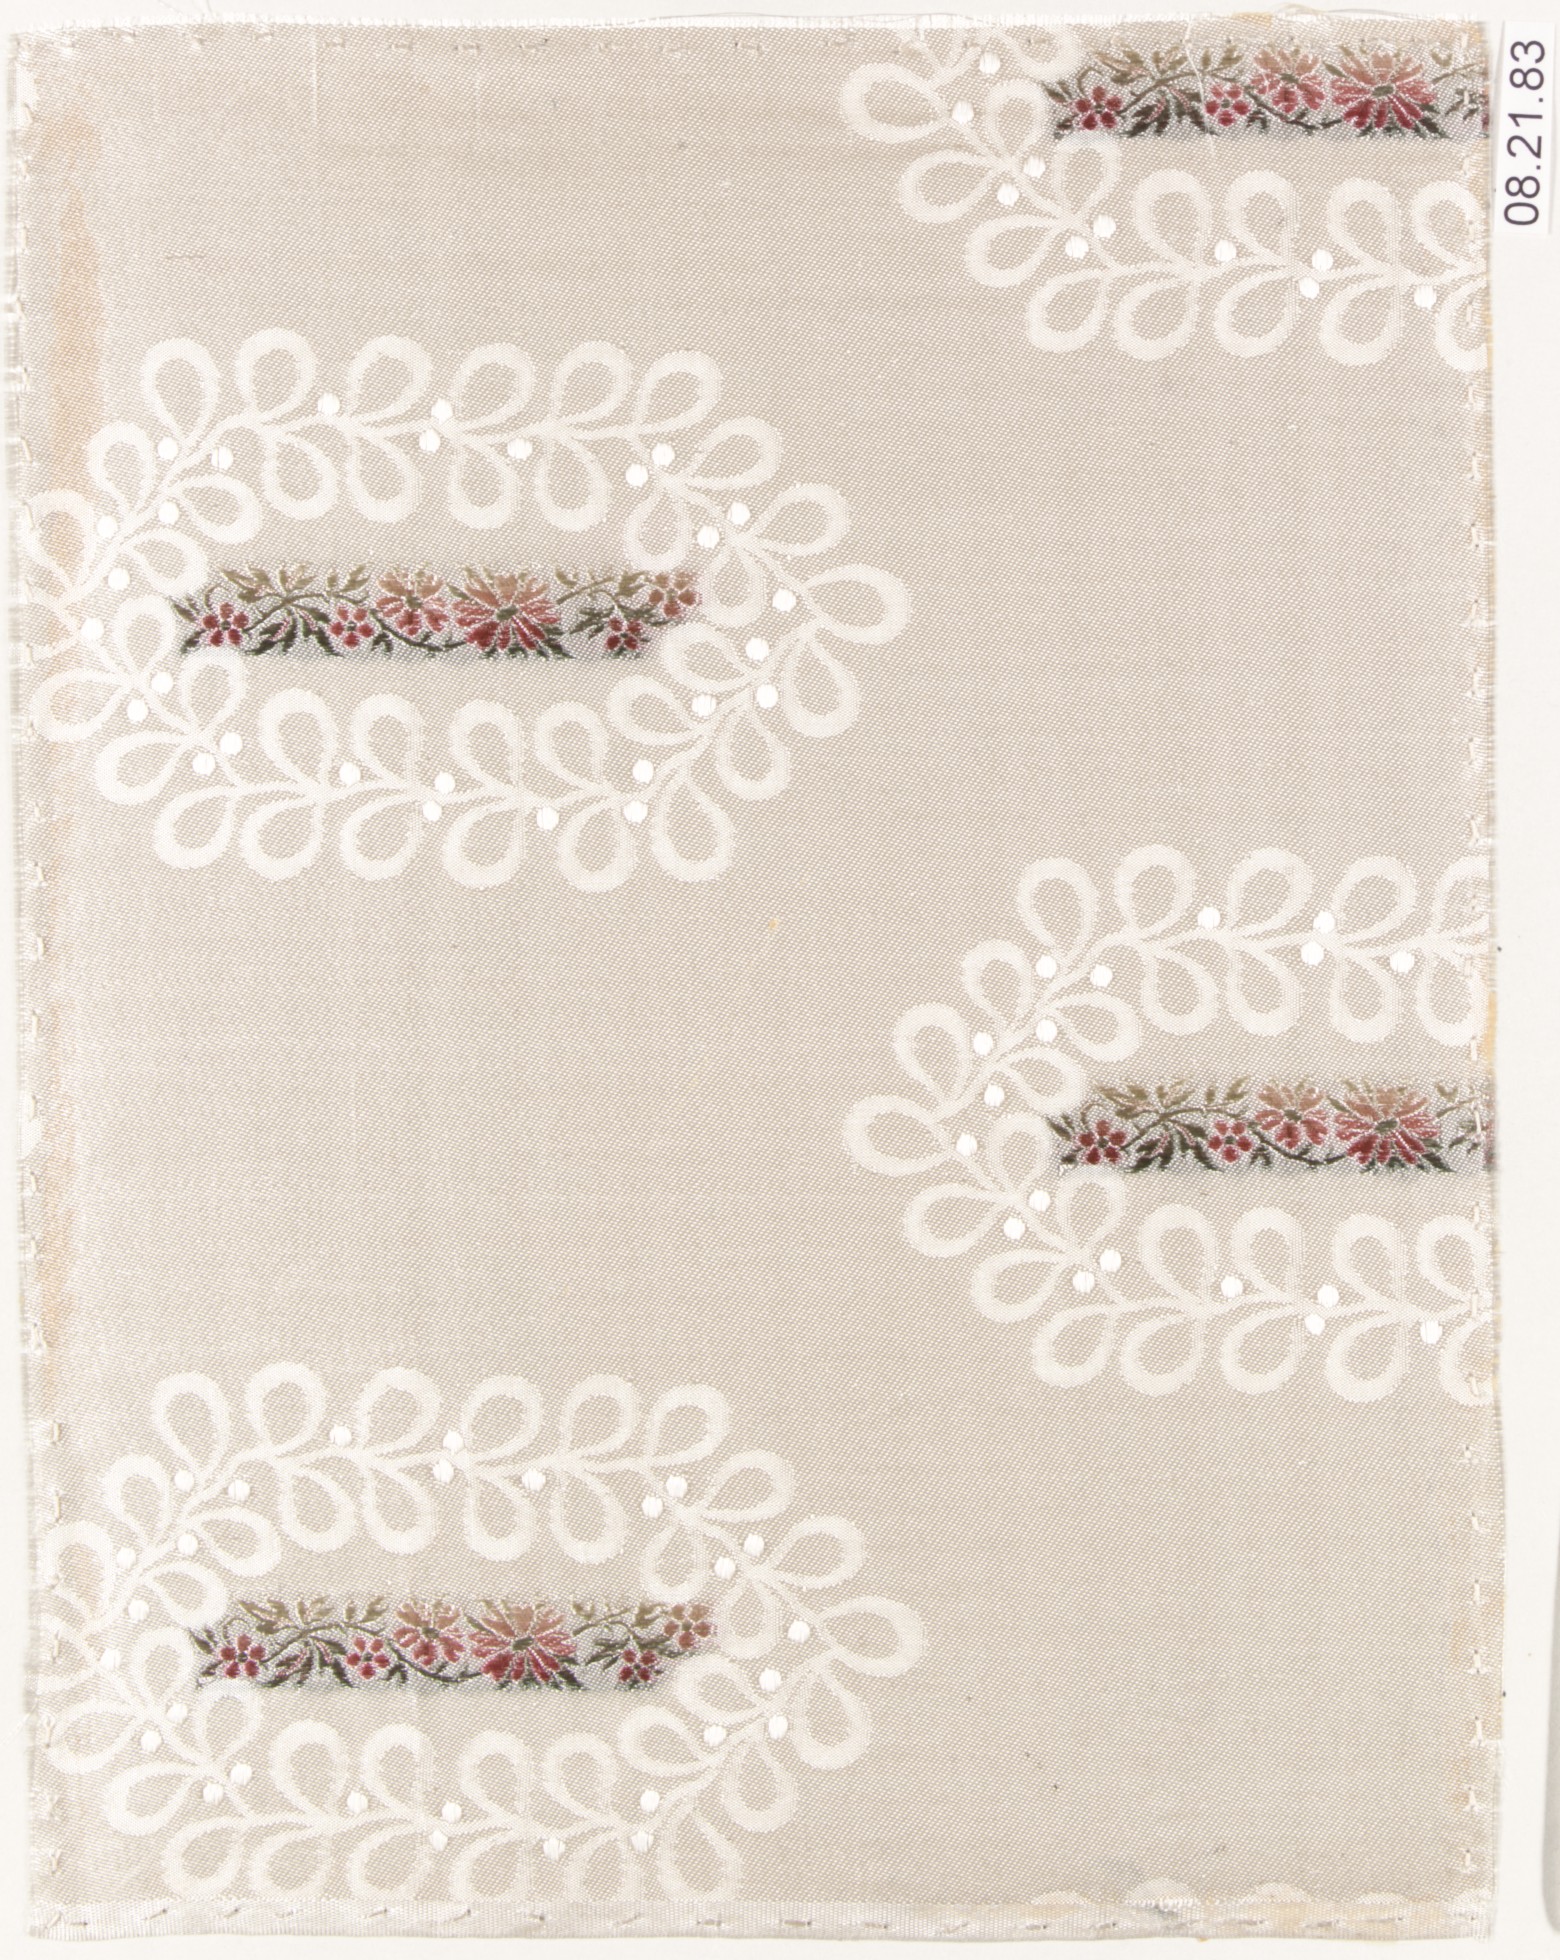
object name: textile sample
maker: Anonymous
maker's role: designer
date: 1900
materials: silk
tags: flowers